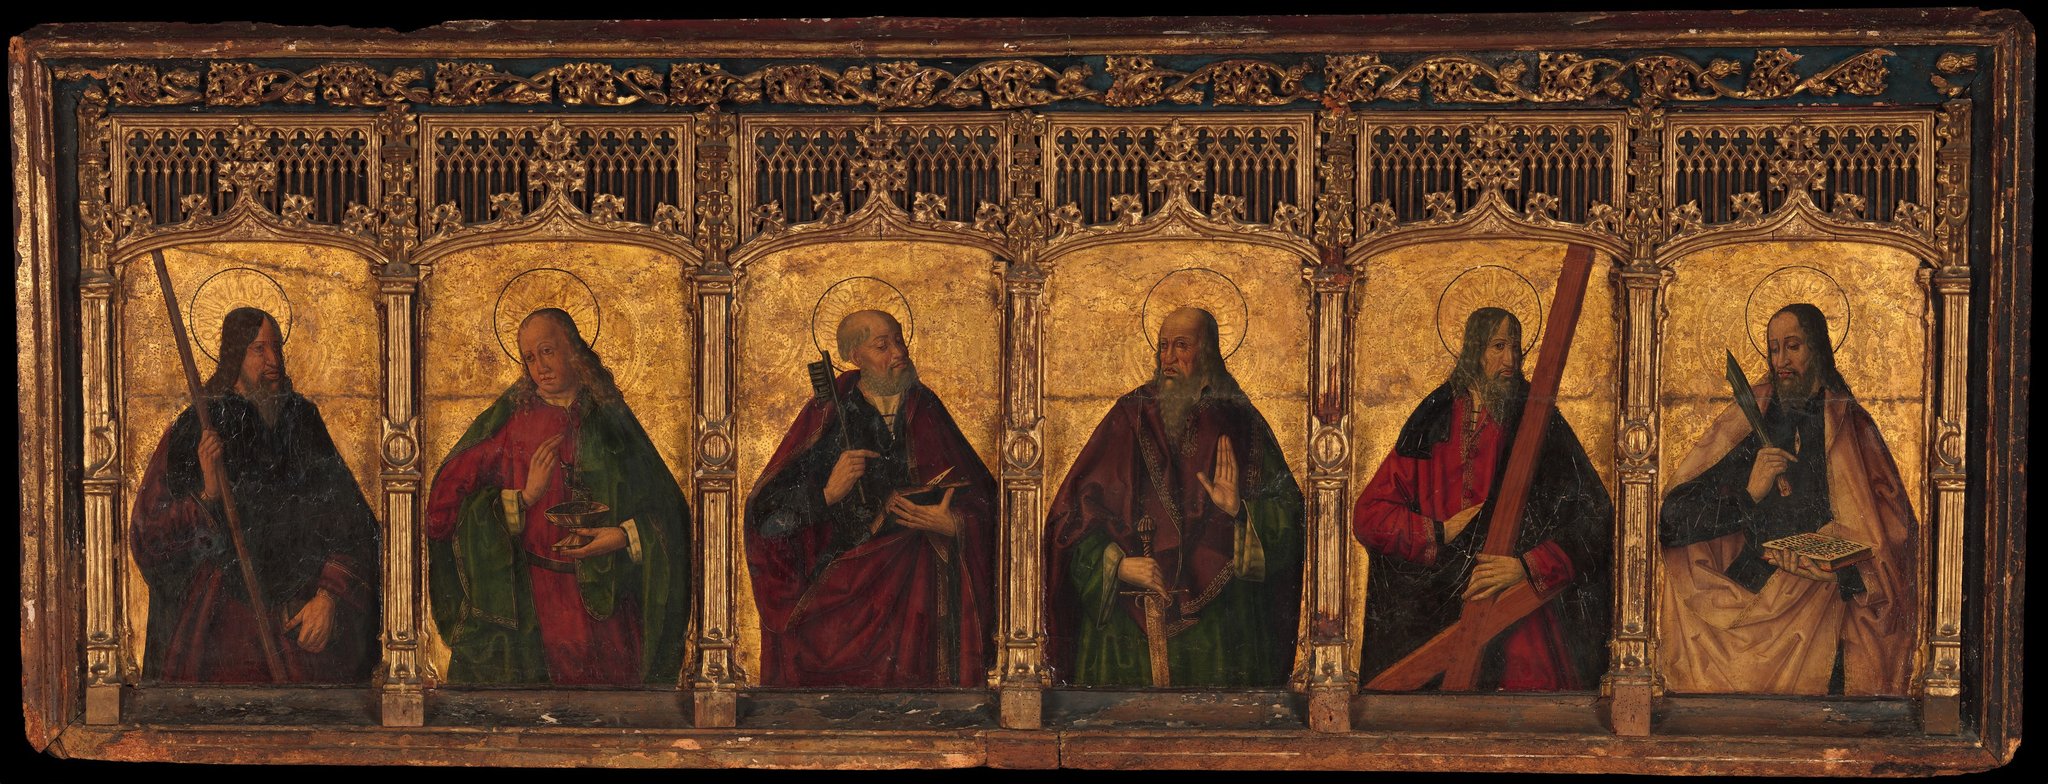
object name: painting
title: Six Apostles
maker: spanish (oña) painter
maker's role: artist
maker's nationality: spanish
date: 1470-1499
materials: gold leaf, paint, wood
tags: apostles,saint john the evangelist,saint paul,saint peter,saint bartholomew,saint andrew